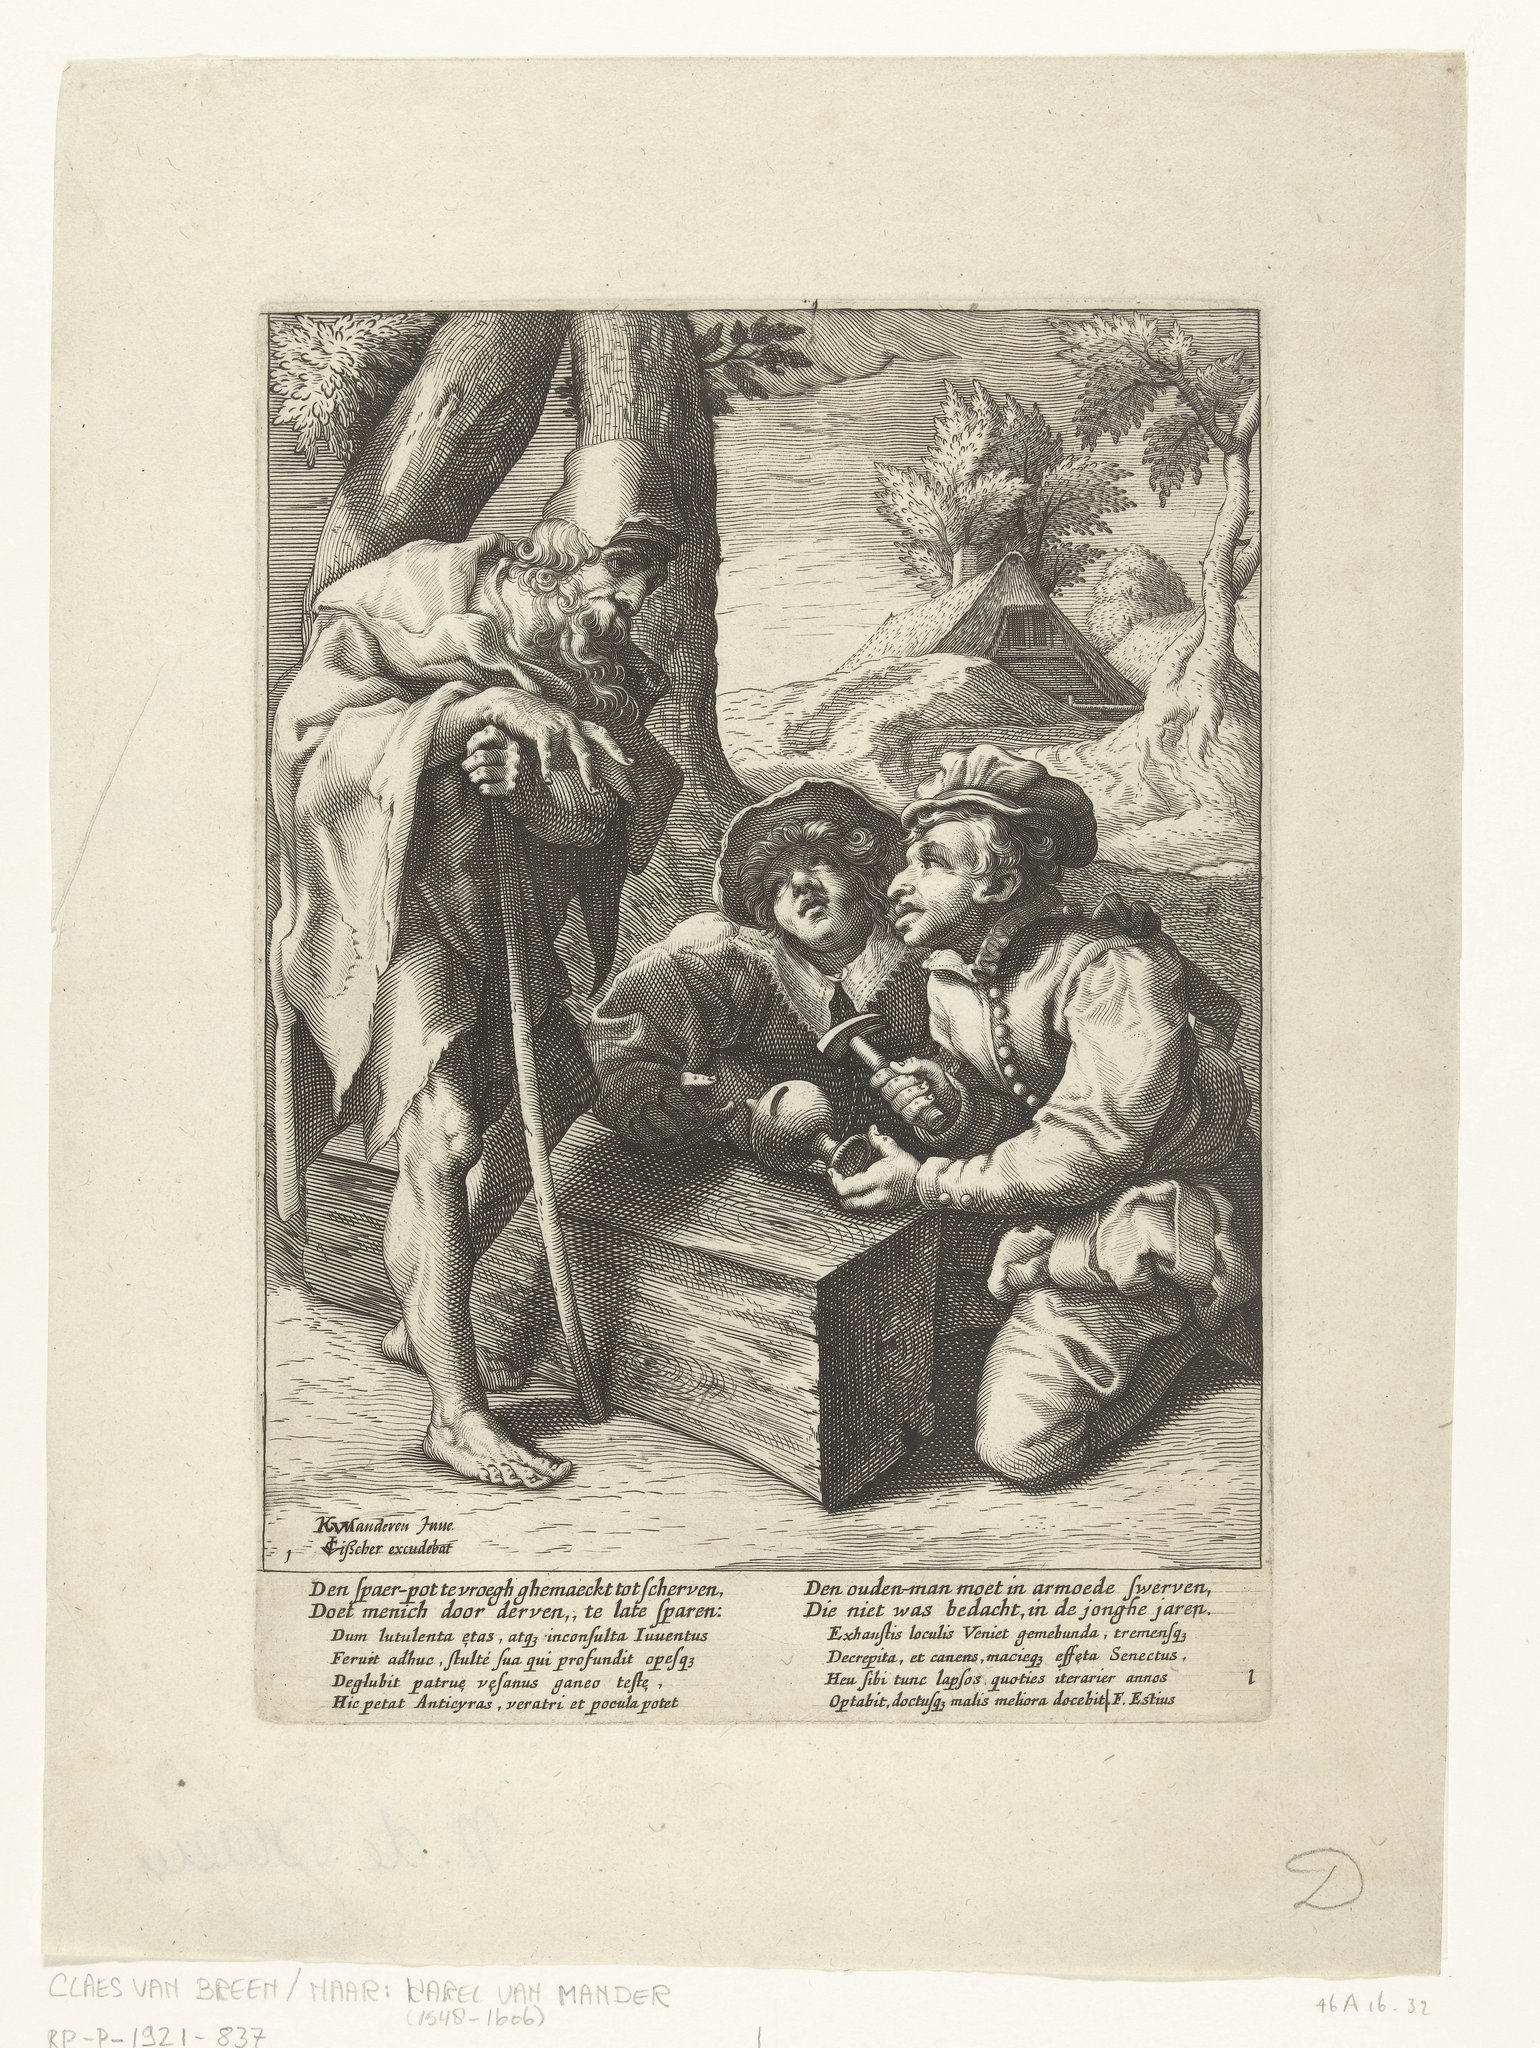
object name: print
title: Spreekwoorden naar Karel van Mander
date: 1590-1594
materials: paper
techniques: engraving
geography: amsterdam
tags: the rich, contrast between rich and poor, wealth, opulence; 'opulenza', 'richezza' (ripa), poverty; 'povertà', 'povertà del doni', 'povertà in uno ch'habbia bell'ingegno' (ripa), money-chest, treasure-chest, money-box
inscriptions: collector's mark: Lugt 2233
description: Twee jongens staan op het punt om hun spaarpot stuk te slaan met een hamer. Een arme oude man die op een stok leunt wijst hen erop dat ze misschien nog beter even kunnen blijven sparen. Anders vergaat het hen als hem. De man maakt een spreekgebaar met drie uitgestrekte vingers.